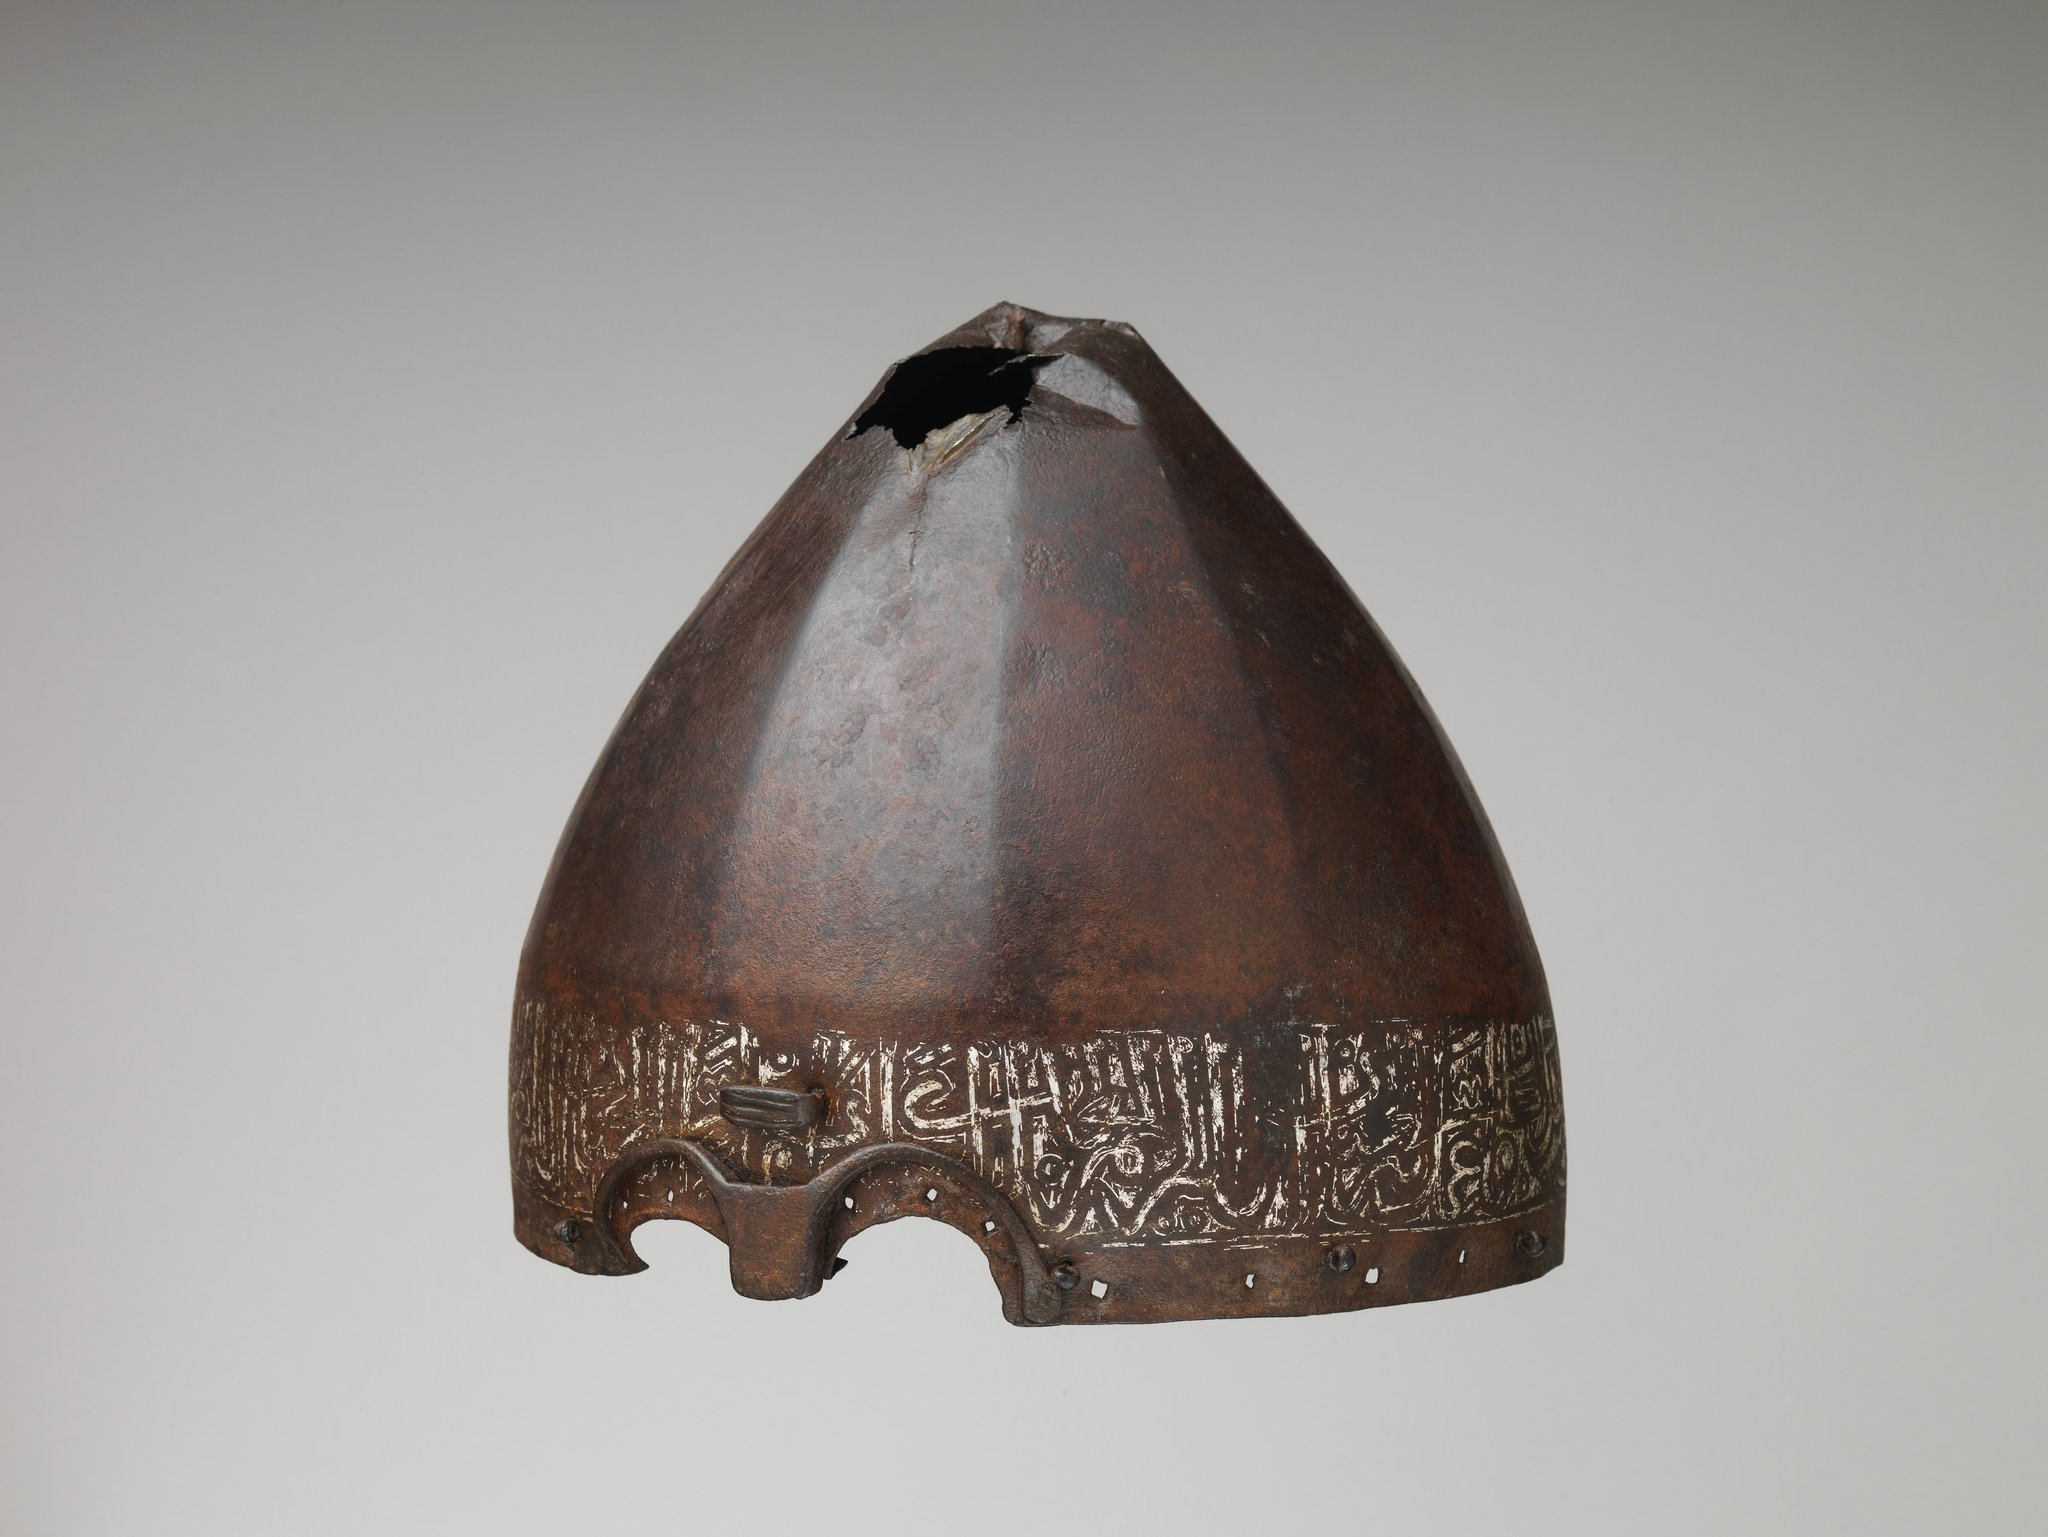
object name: helmet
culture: central asian or russian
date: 1342-1357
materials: silver, steel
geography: china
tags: arabic